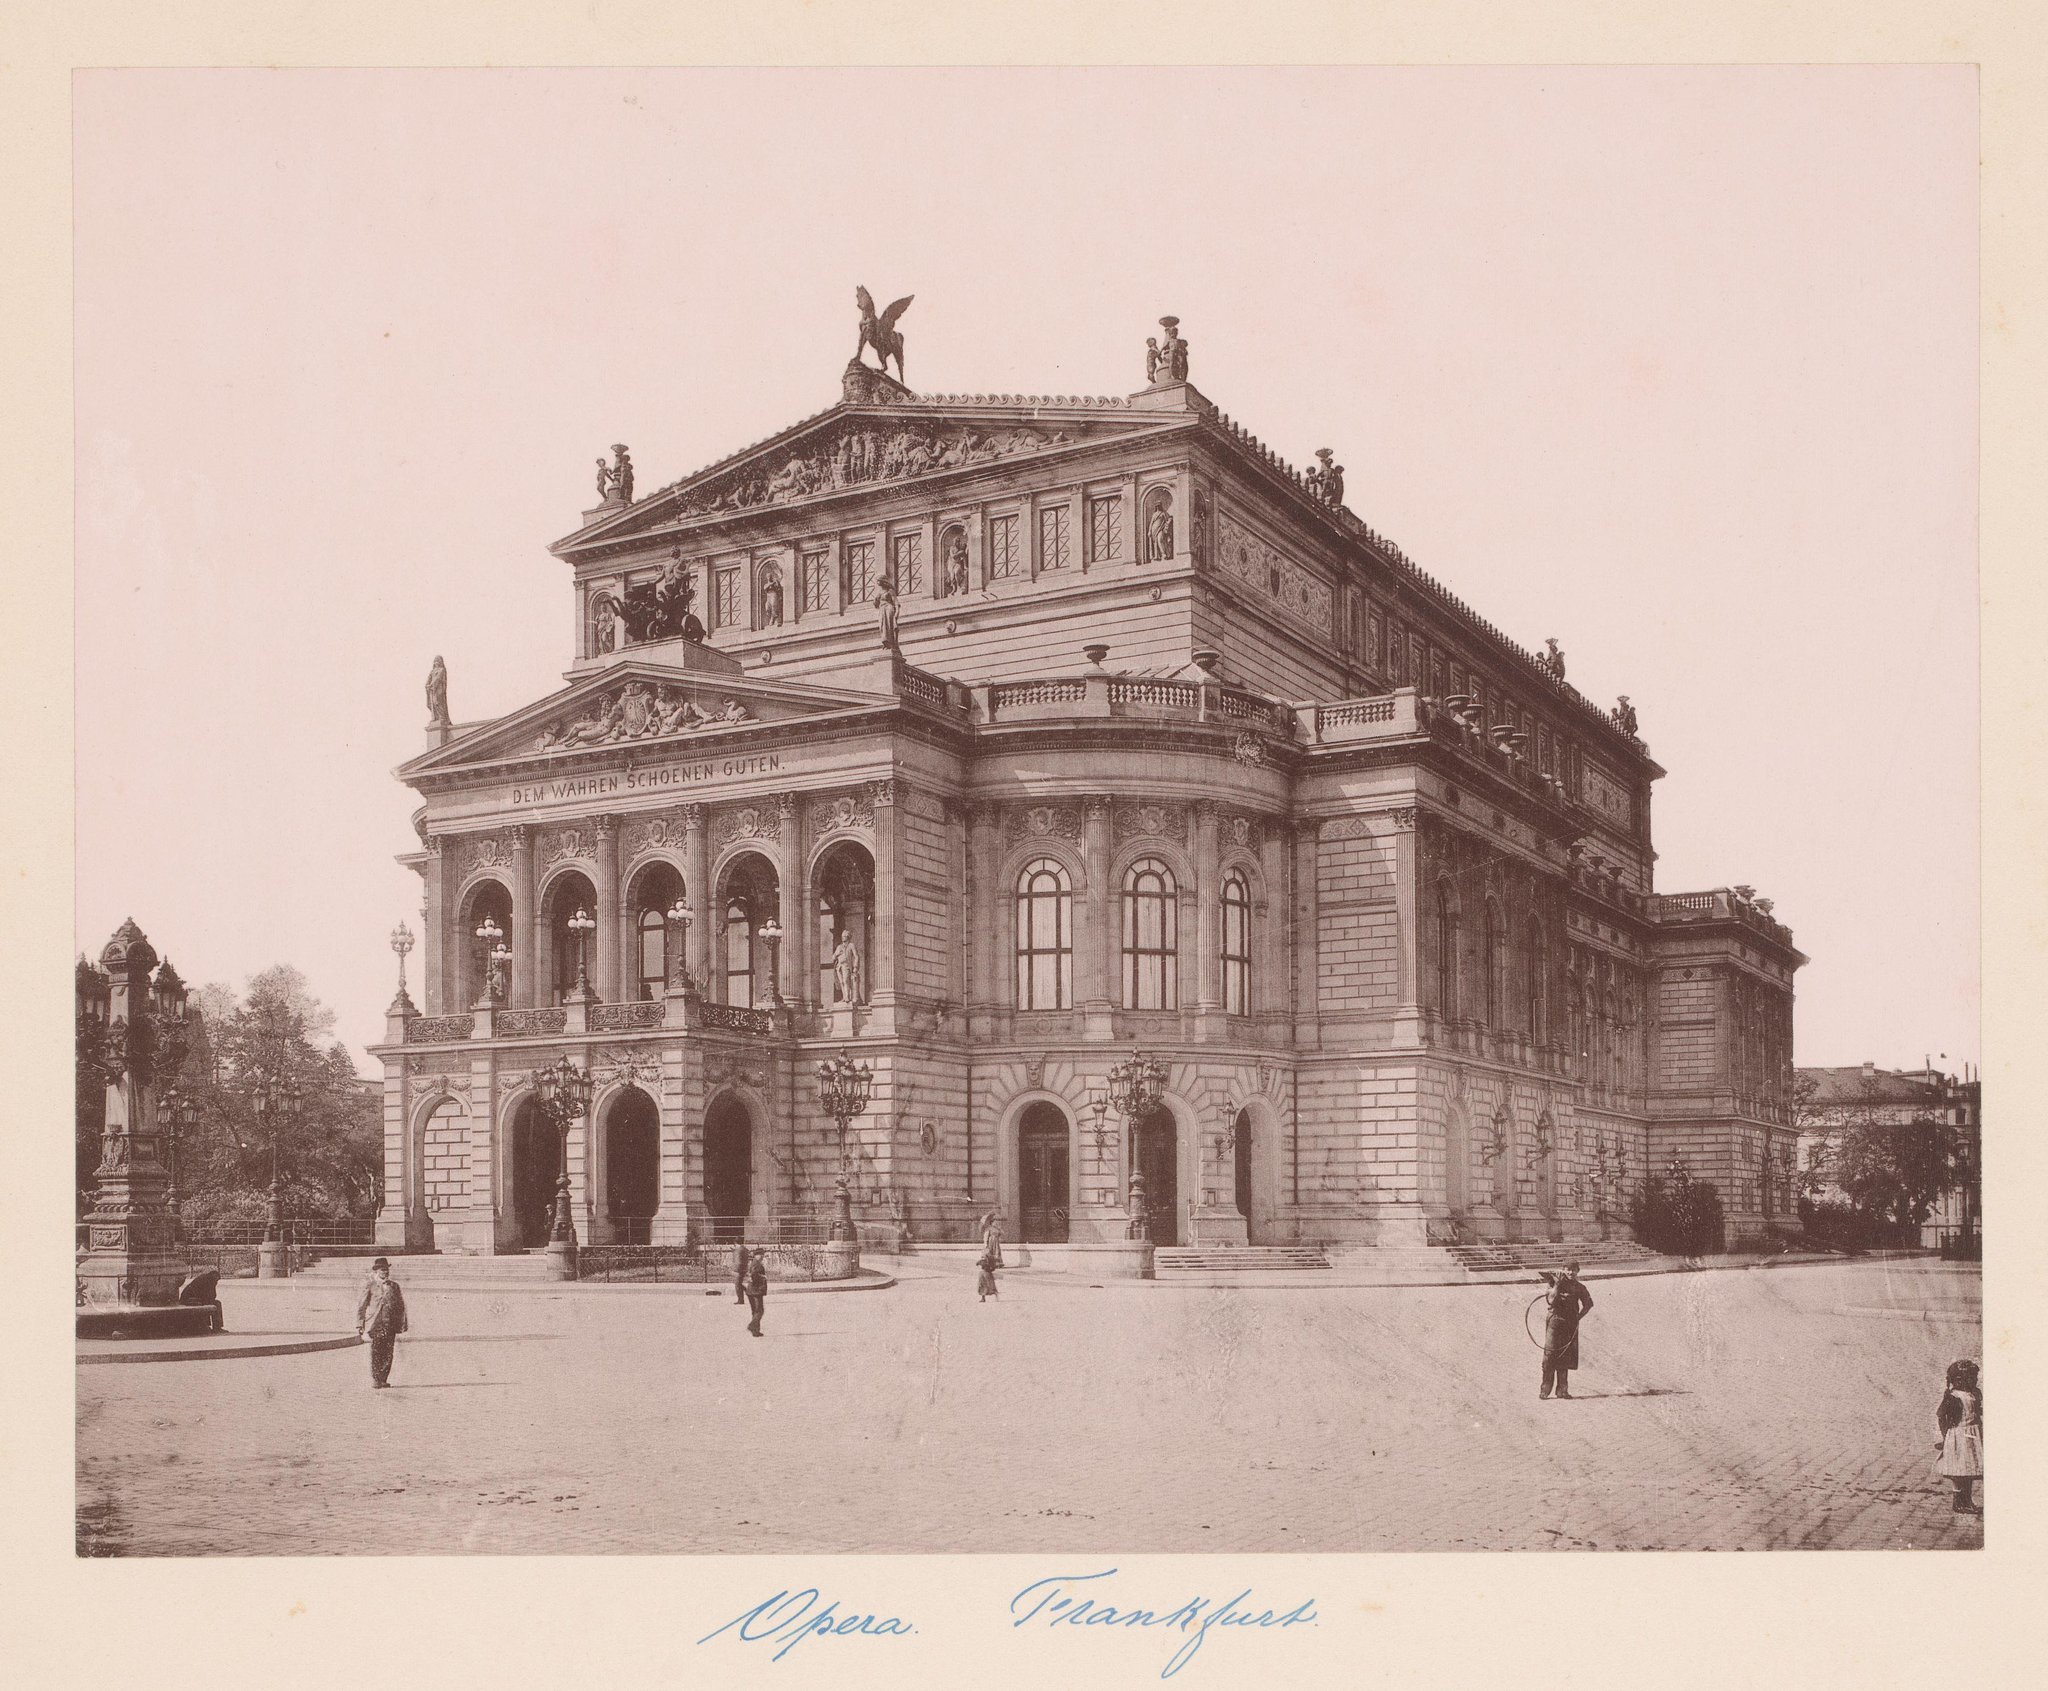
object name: photograph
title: "Alte Oper", Frankfurt am Main, Duitsland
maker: Anonymous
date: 1880-1895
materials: cardboard, paper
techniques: albumen print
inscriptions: caption: ‘Opera. Frankfurt.’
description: Gezicht op het operagebouw op een plein. Het gebouw, van de hand van architect Richard Lucae (1829-1877) werd in 1880 in aanwezigheid van Kaiser Wilhelm I geopend. Op 23 maart 1944 werd het grotendeels verwoest, maar is herbouwd.